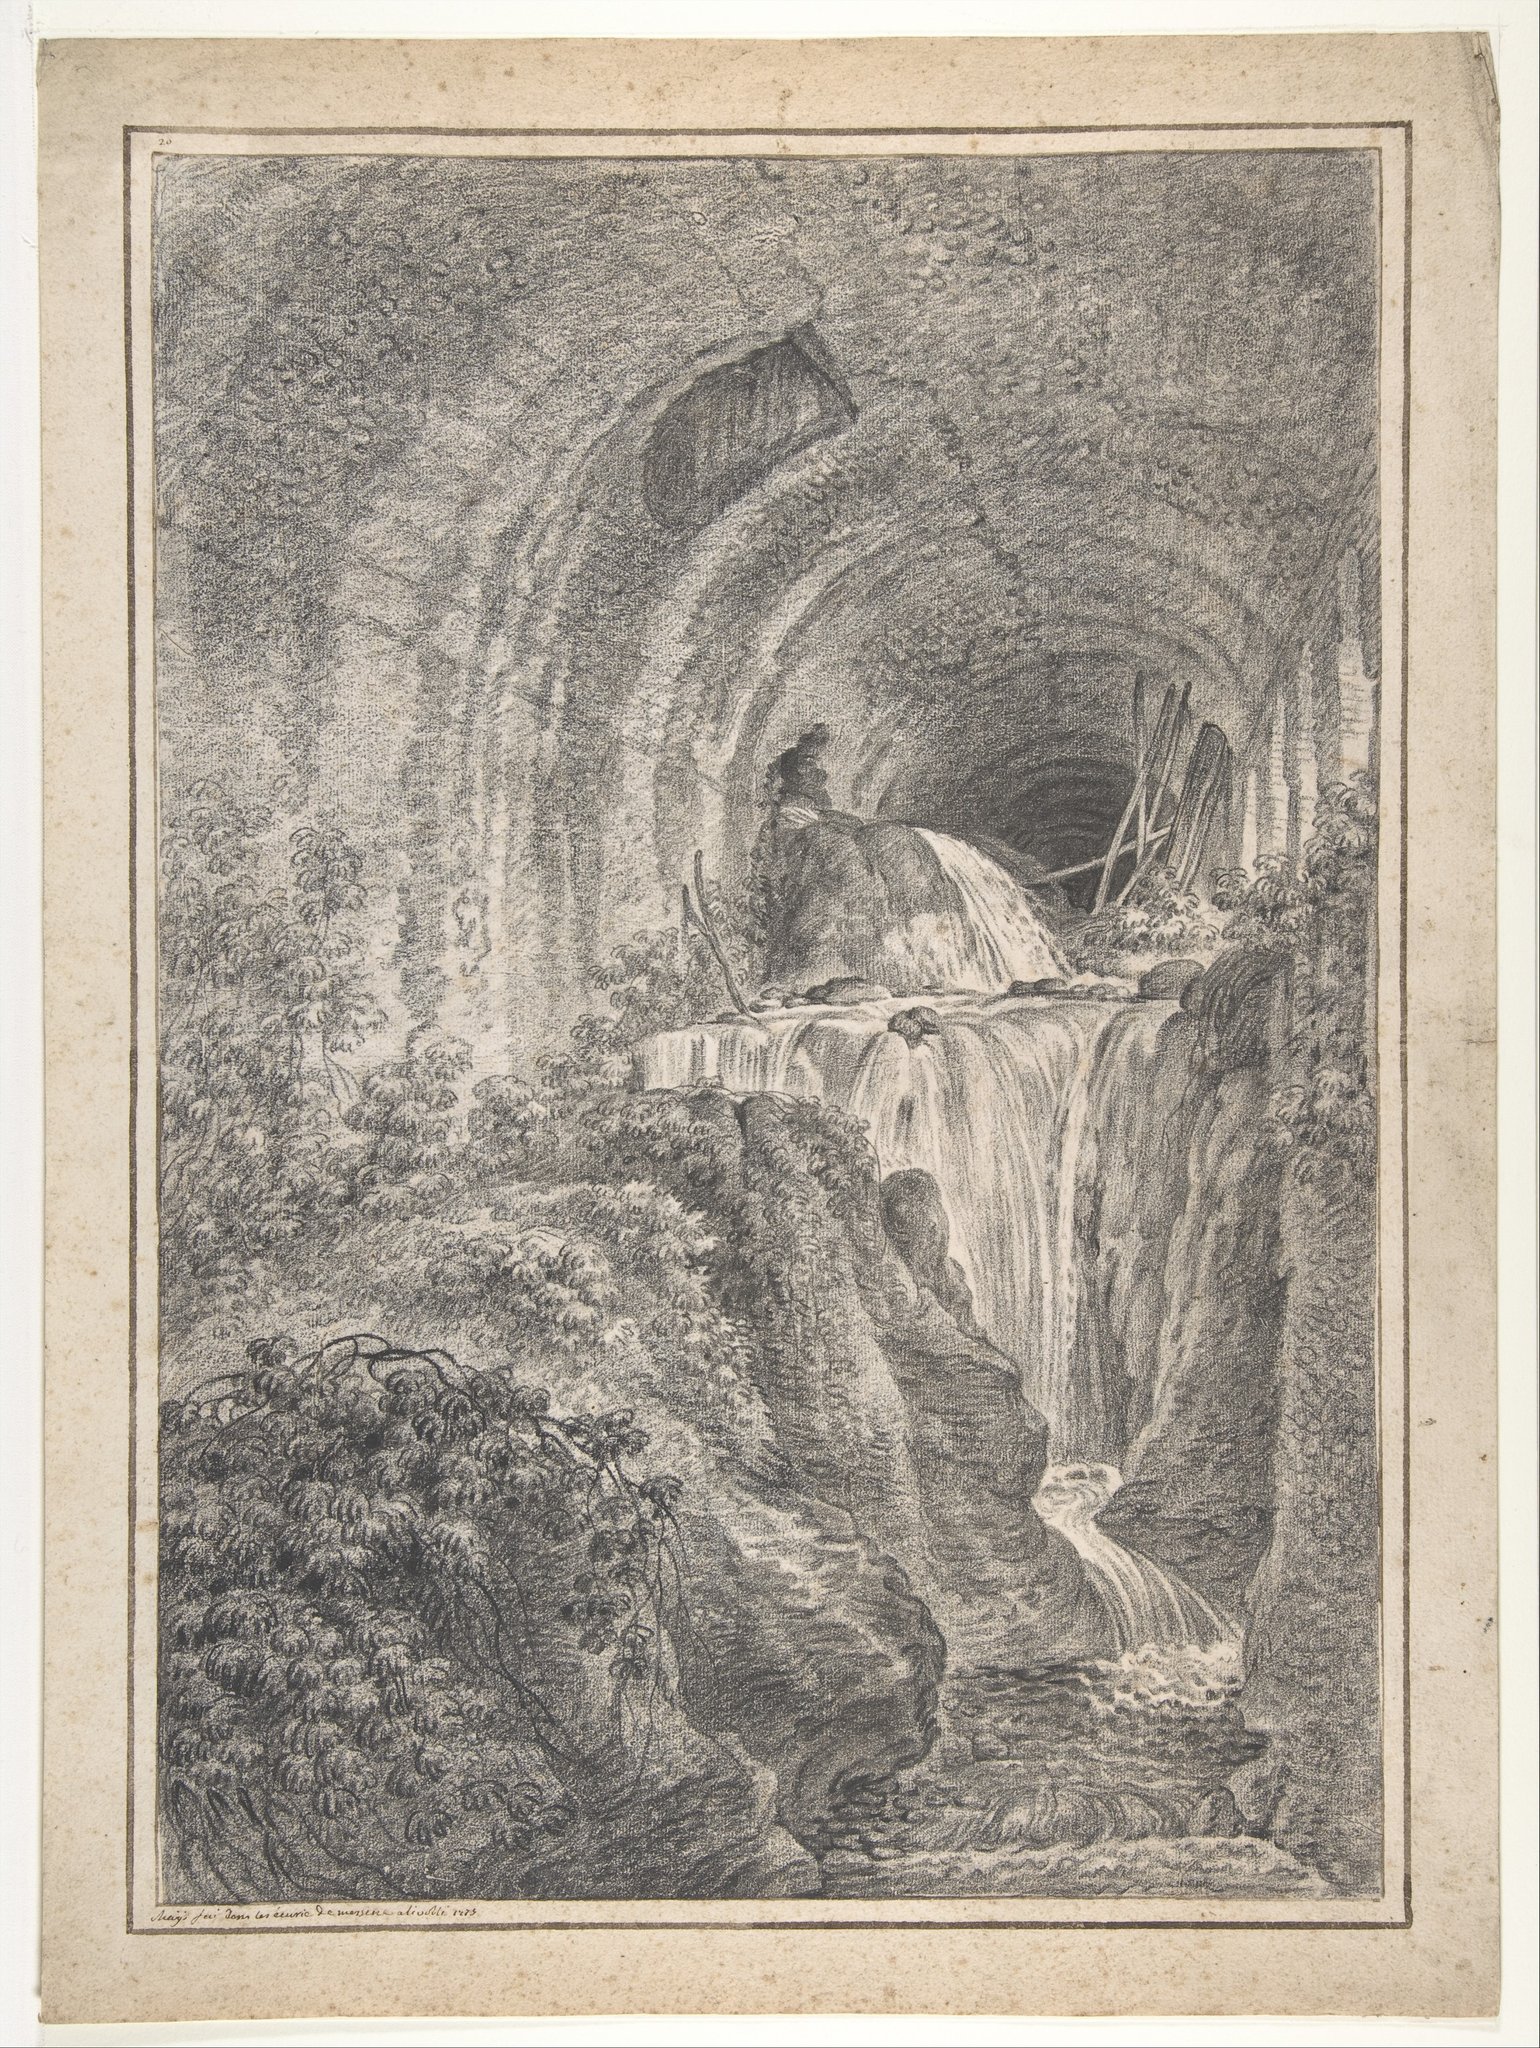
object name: drawing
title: The So-Called Stables of Maecenas at Tivoli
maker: louis chaix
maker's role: artist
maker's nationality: french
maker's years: 1740-1811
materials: chalk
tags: buildings,plants